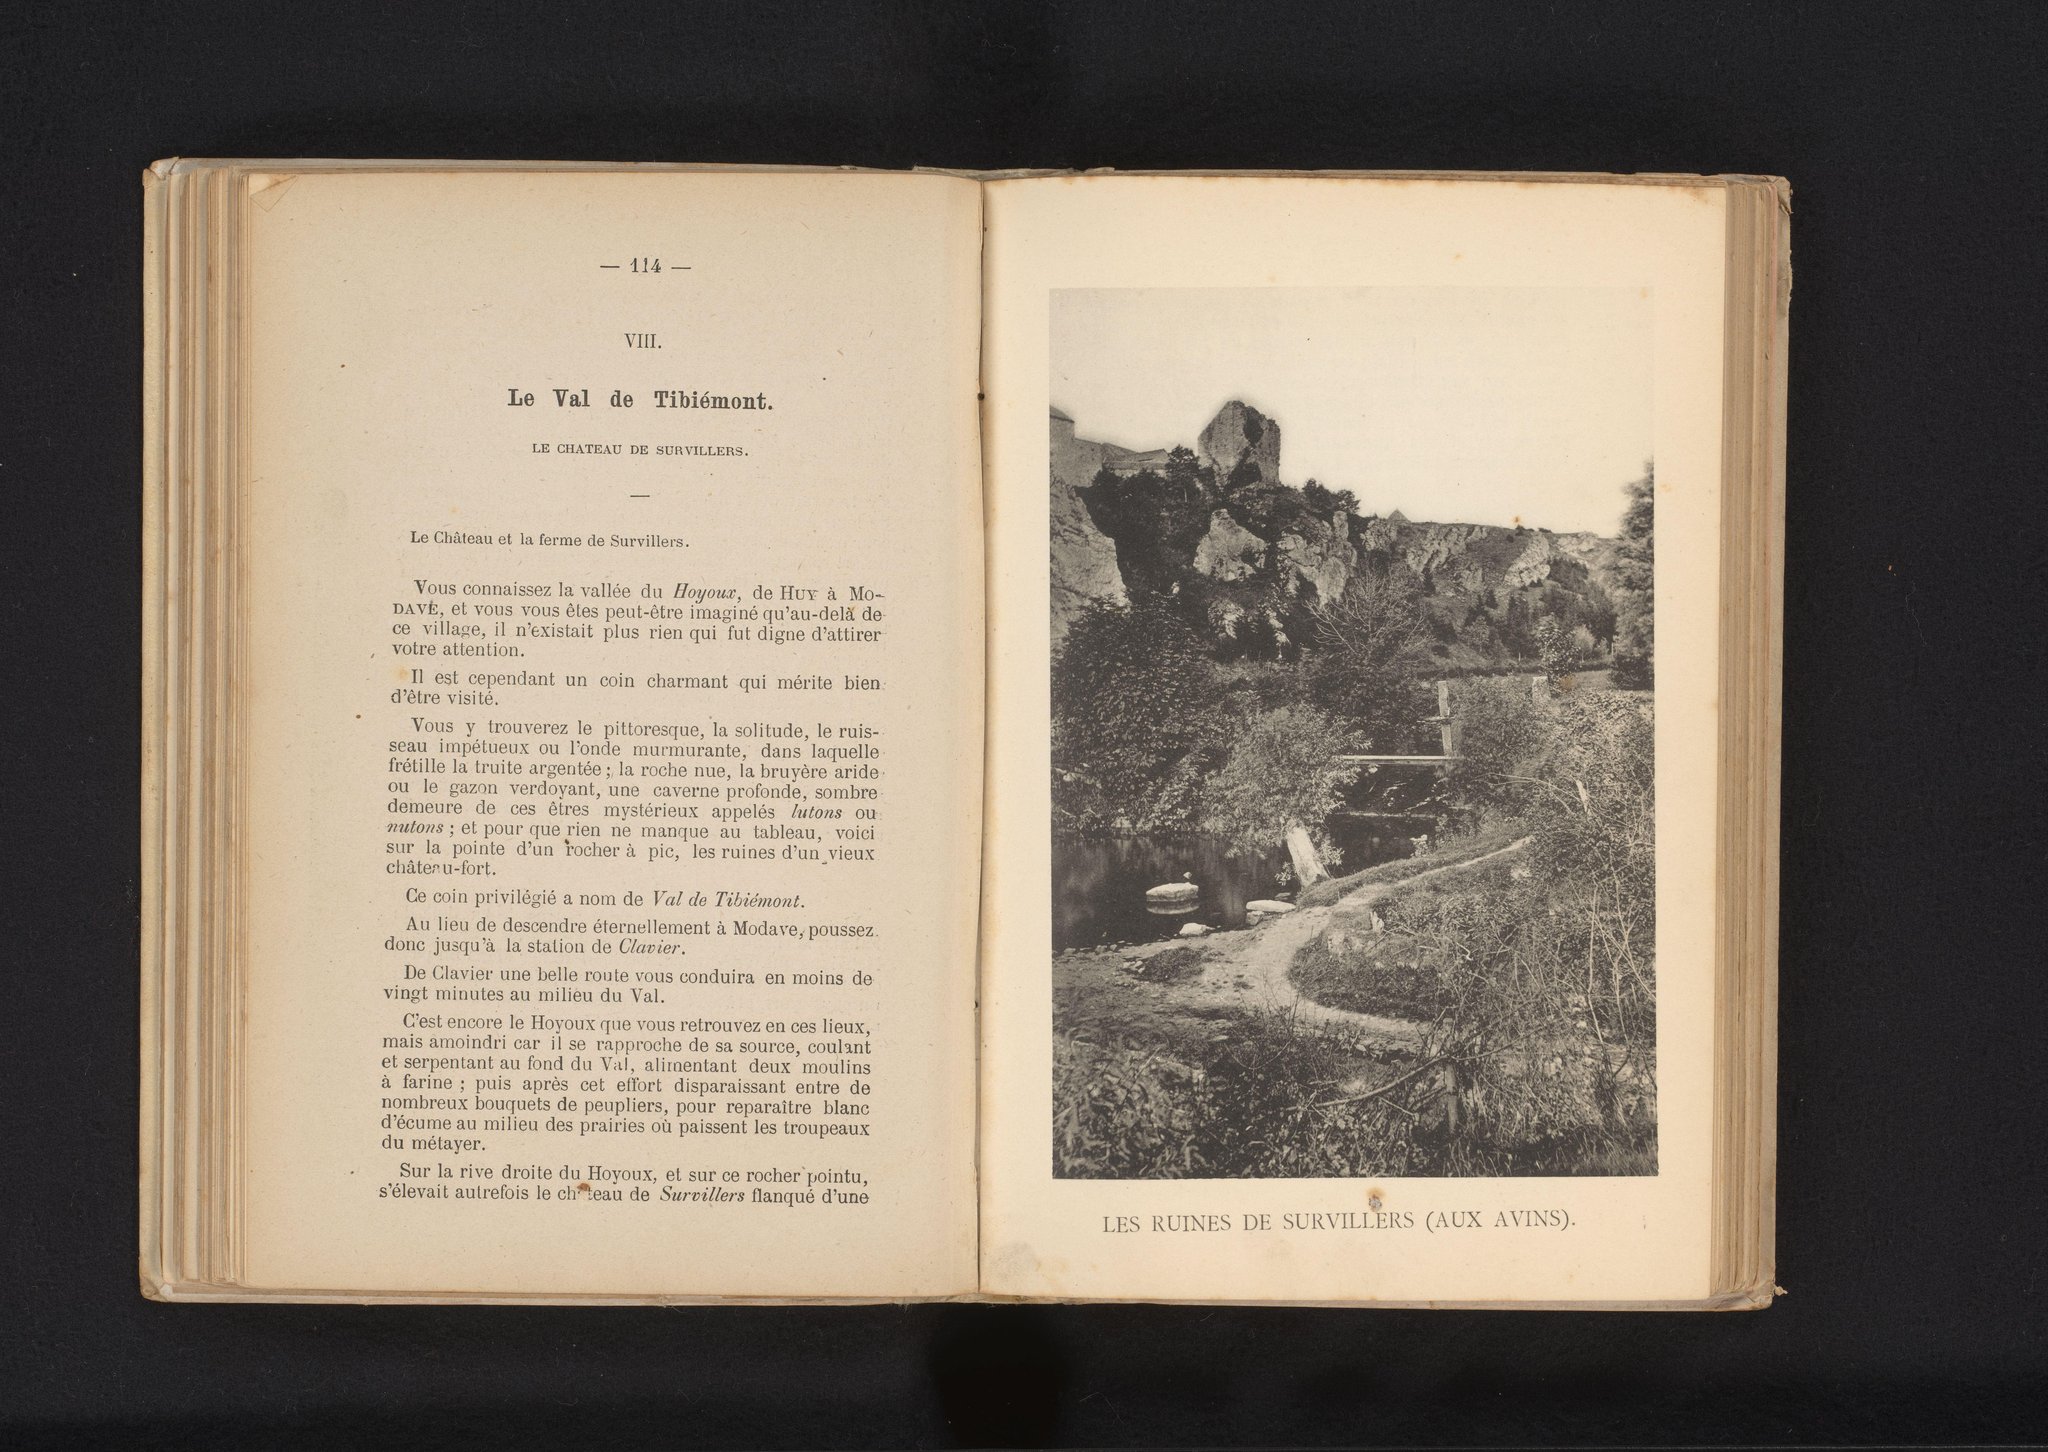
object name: photomechanical print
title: Gezicht op de ruïnes van Château de Survillers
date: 1885-1890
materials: paper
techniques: photograph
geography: brussels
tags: landscape with ruins, liège